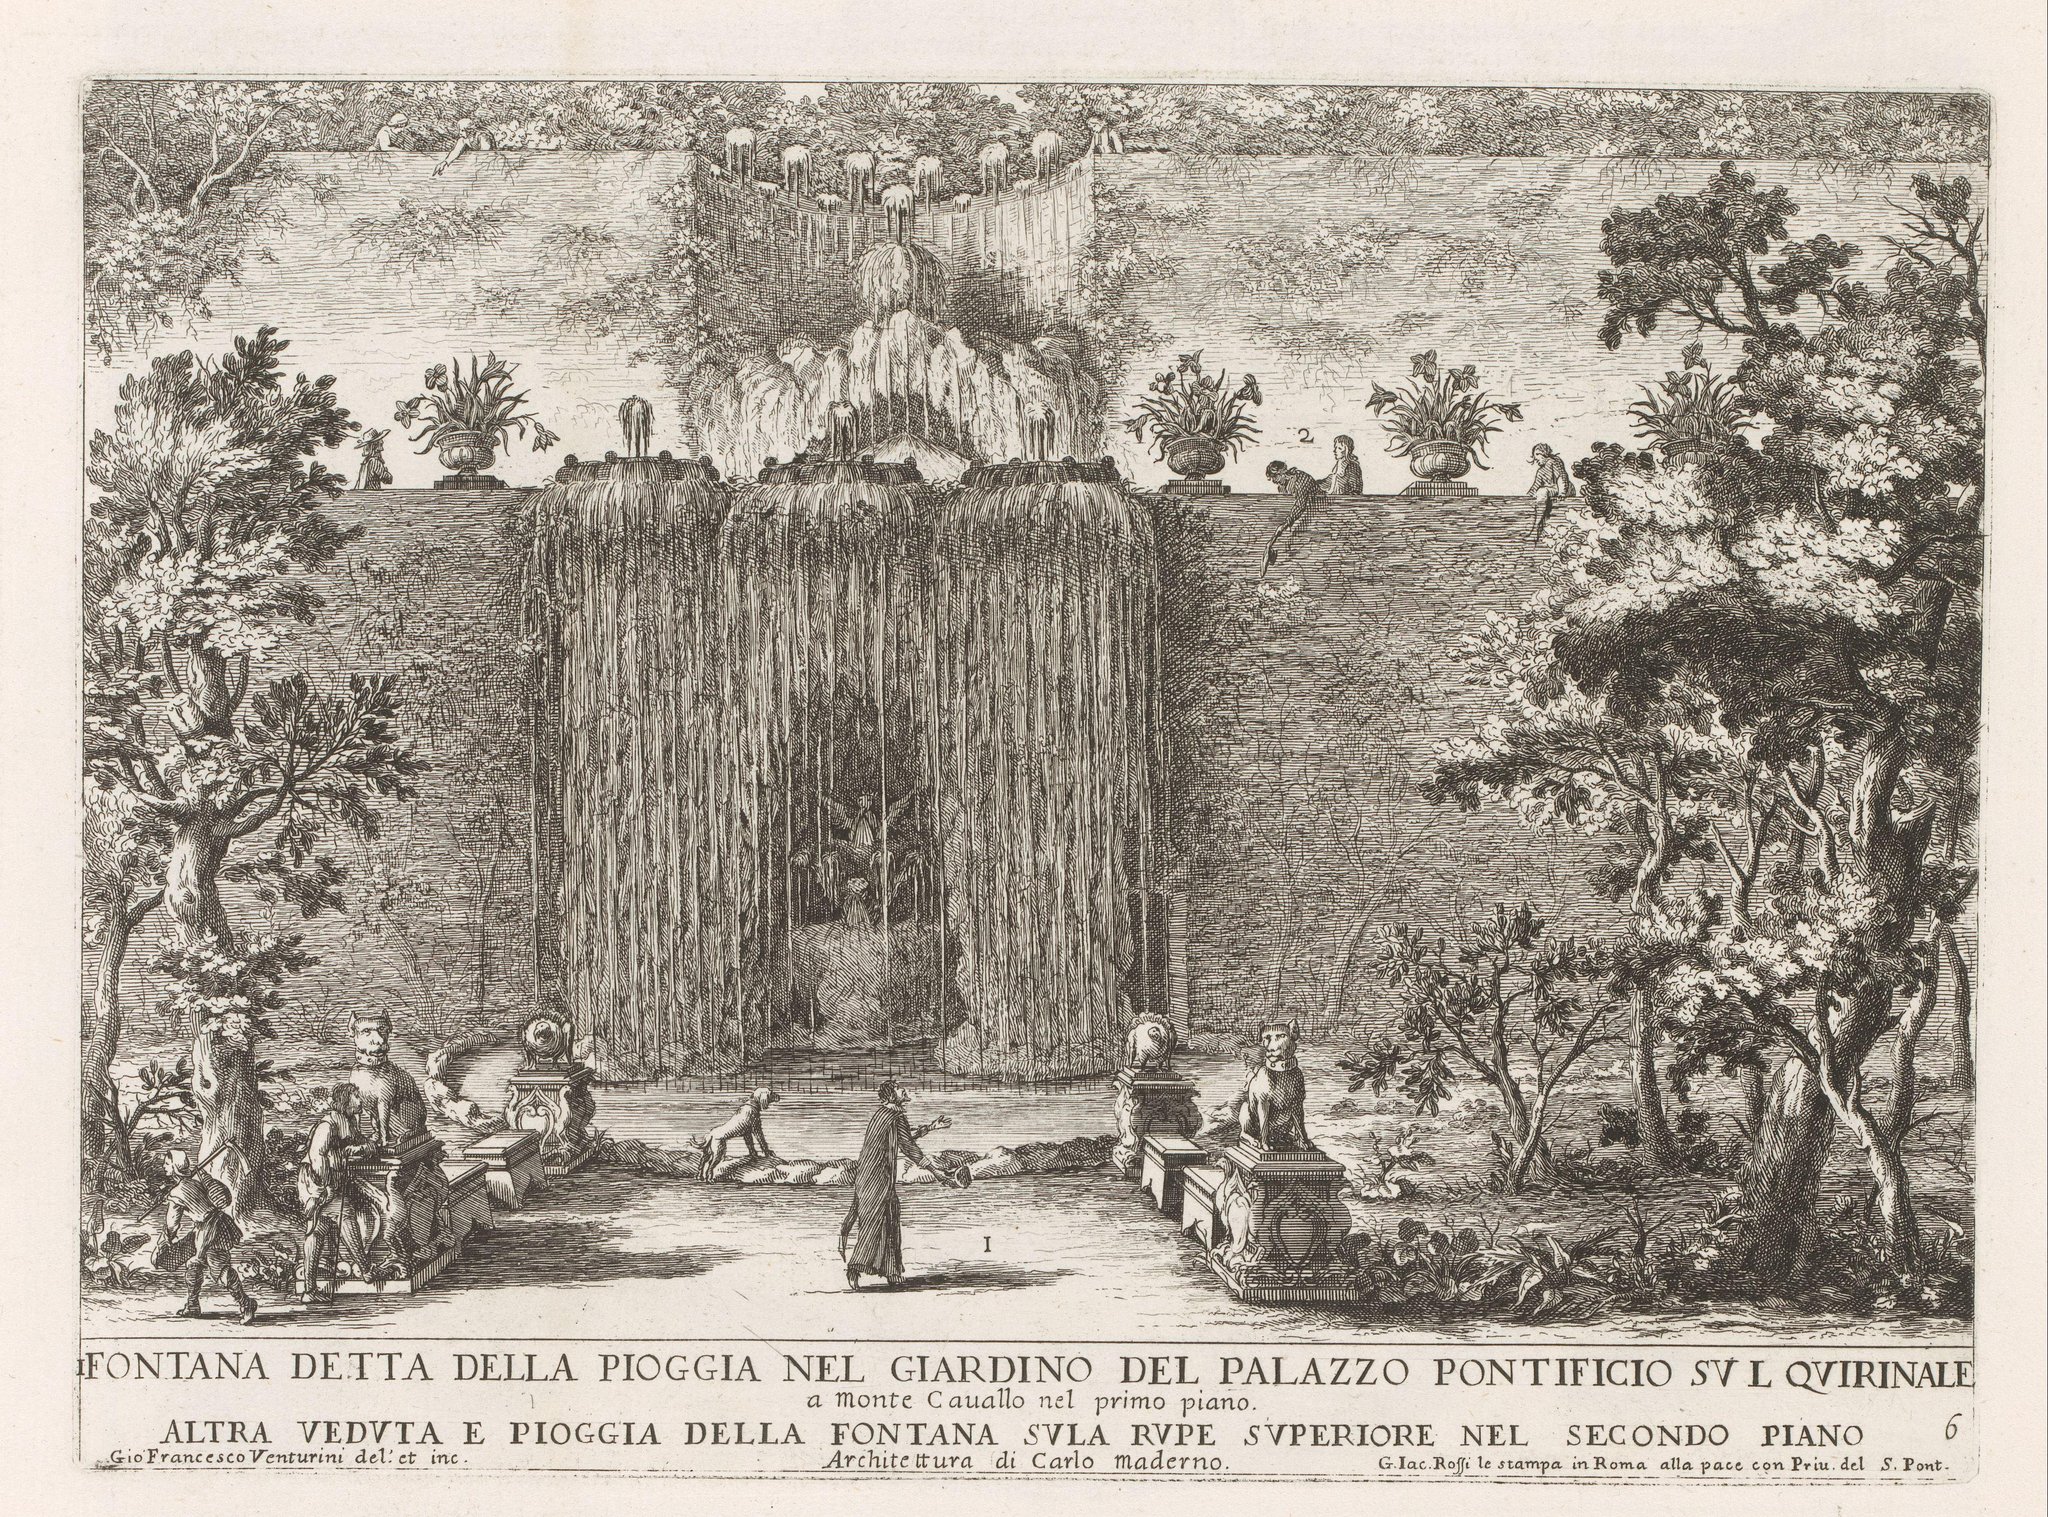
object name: print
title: Fontana detta della pioggia nel giardino del palazzo pontificio sul Quirinale (...)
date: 1653-1691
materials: paper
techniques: etching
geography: italy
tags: ornamental fountain, rome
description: Genummerd rechtsonder: 6. De prent maakt deel uit van een album.